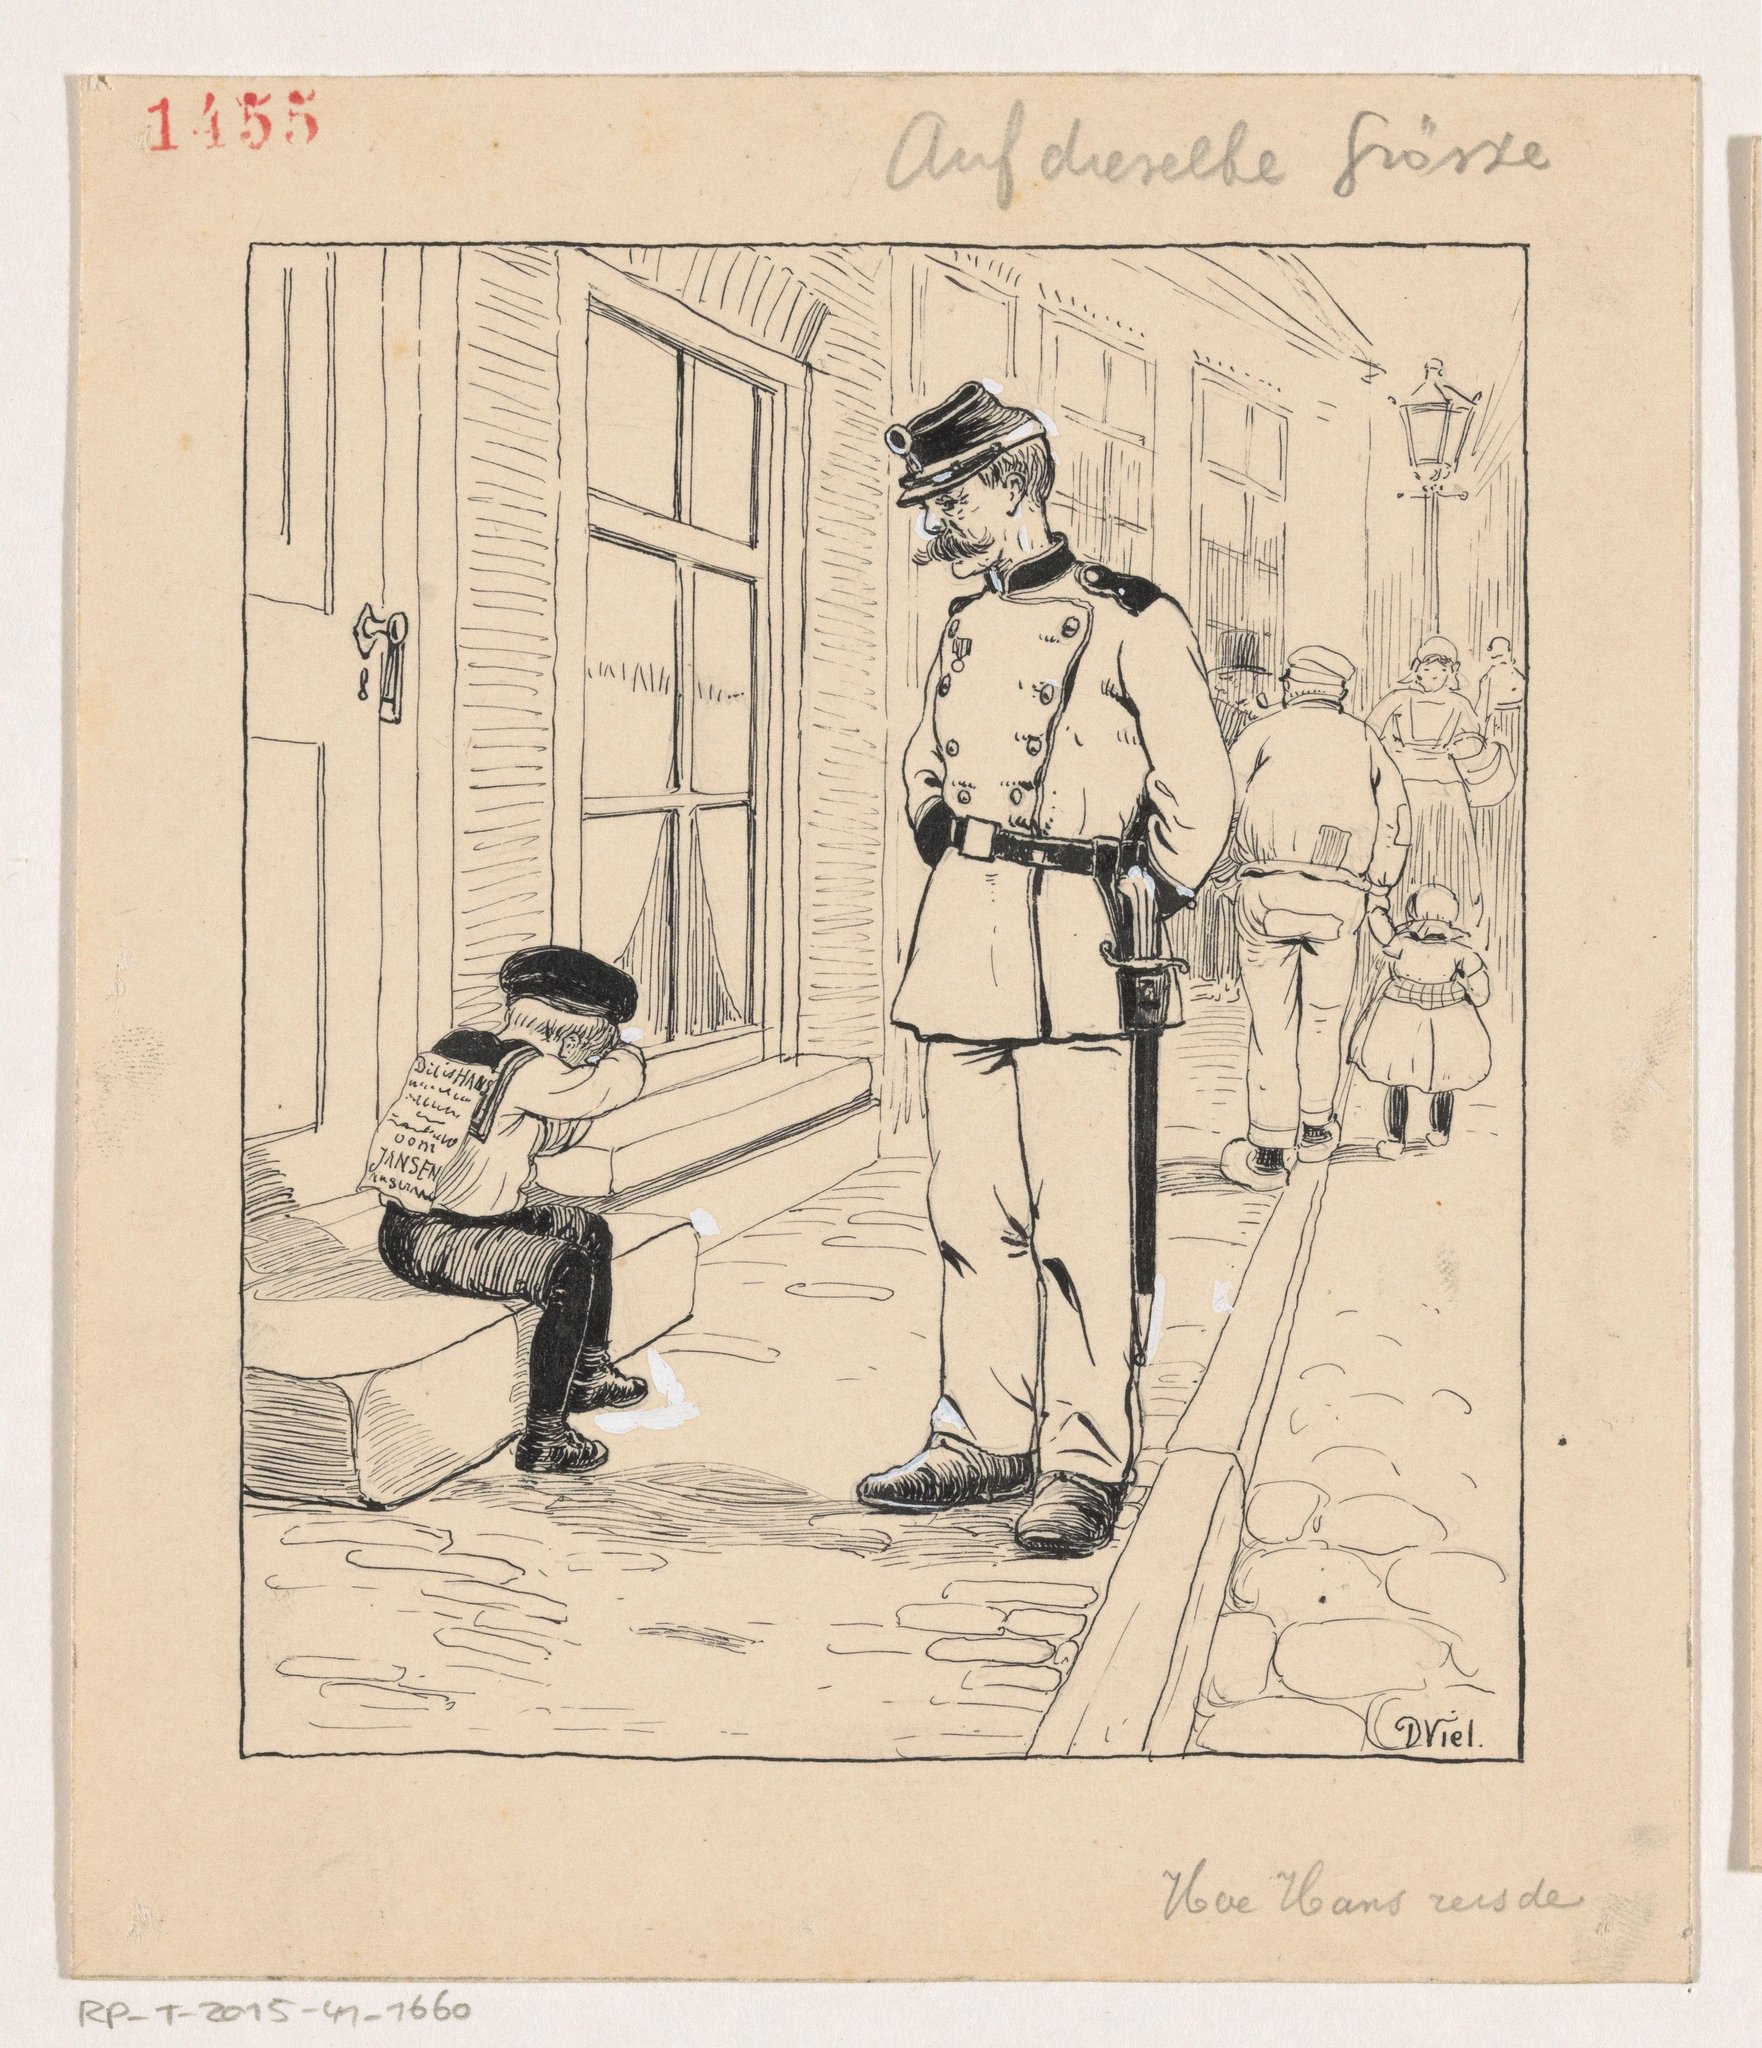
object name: drawing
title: Politieagent bij een huilende Hans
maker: d. viel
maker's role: draughtsman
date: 1915-1935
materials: paint, ink, paper, pencil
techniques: brush, pen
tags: policeman, constable, weeping, street (+ city(-scape) with figures, staffage)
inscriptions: annotation: ‘Hoe Hans reisde’, signature: ‘D Viel.’, collector's mark: Lugt 2228, :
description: In een straat zit Hans huilend op een stoep. Op zijn rug is een vel papier vastgemaakt waarop onder andere staat: 'Ik ben Hans' en 'oom Jansen'. Een politieagent kijkt naar Hans.